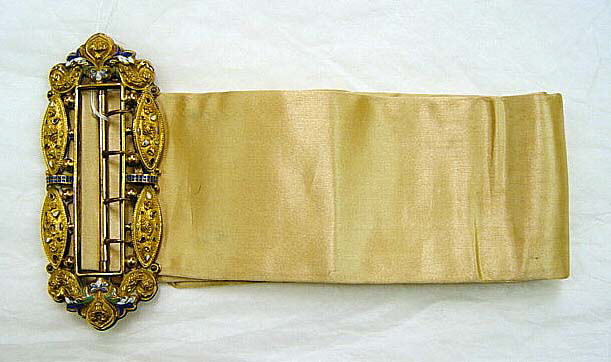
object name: belt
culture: american or european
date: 1830-1839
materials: enamel, metal, silk